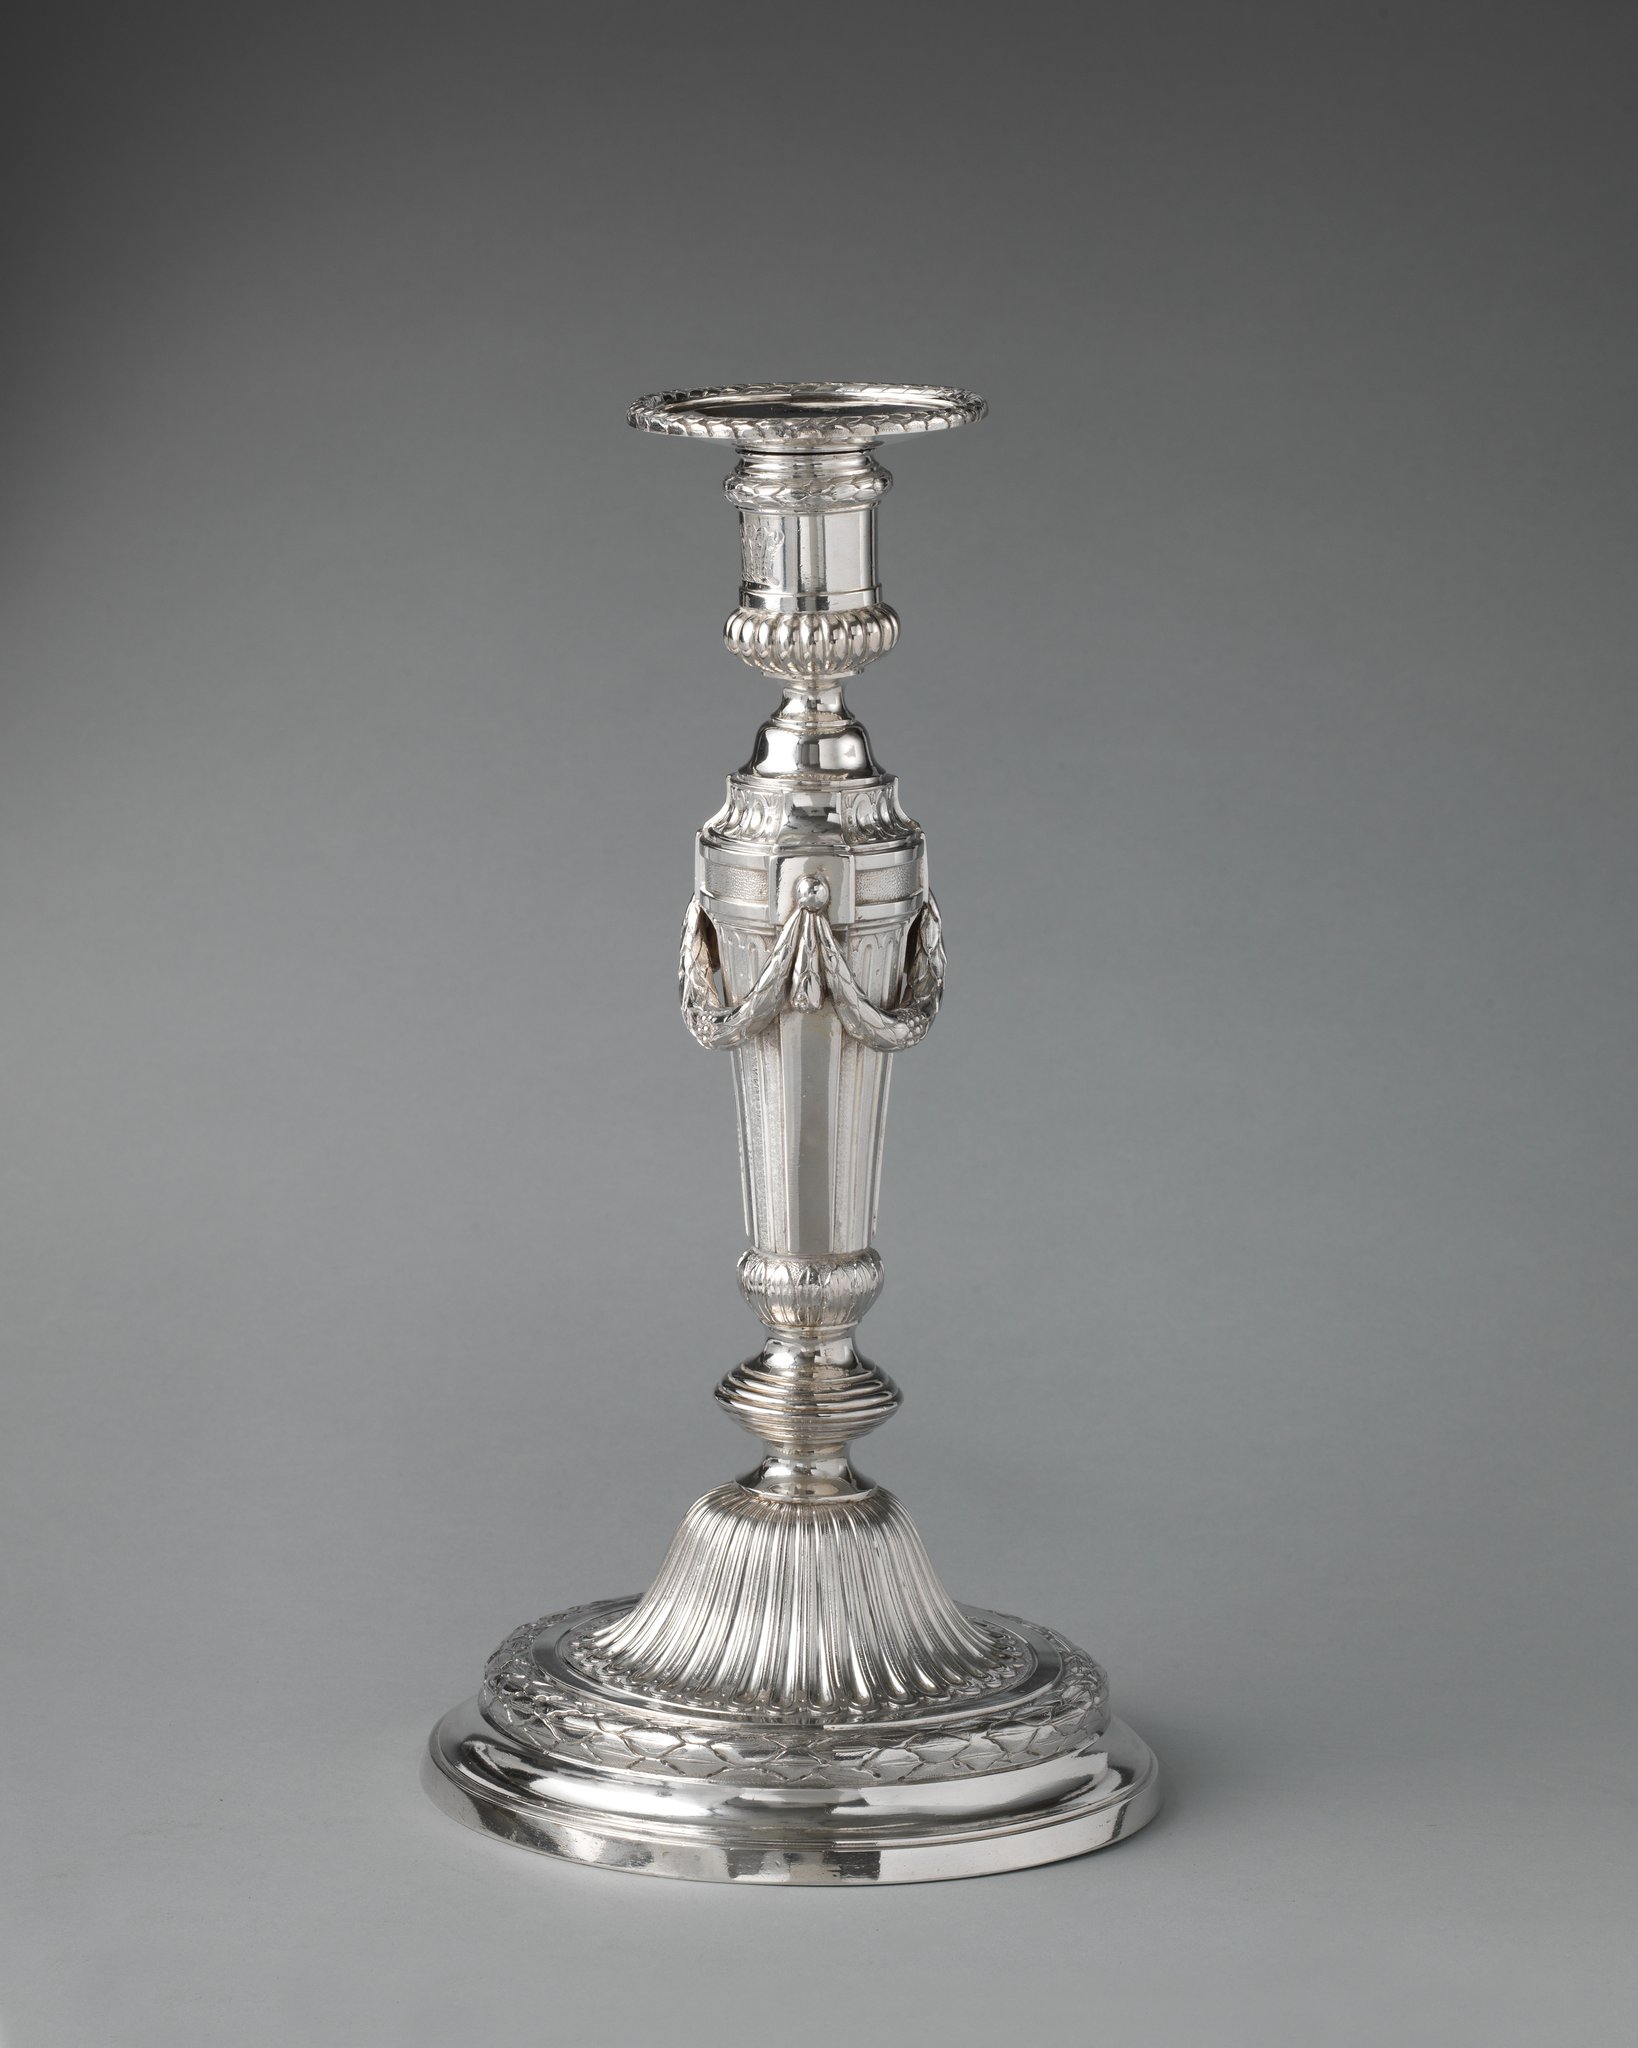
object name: candlestick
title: Candlestick (one of a set of eight)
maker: john romer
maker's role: maker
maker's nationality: british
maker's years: 1712-1815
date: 1768-1769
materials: silver